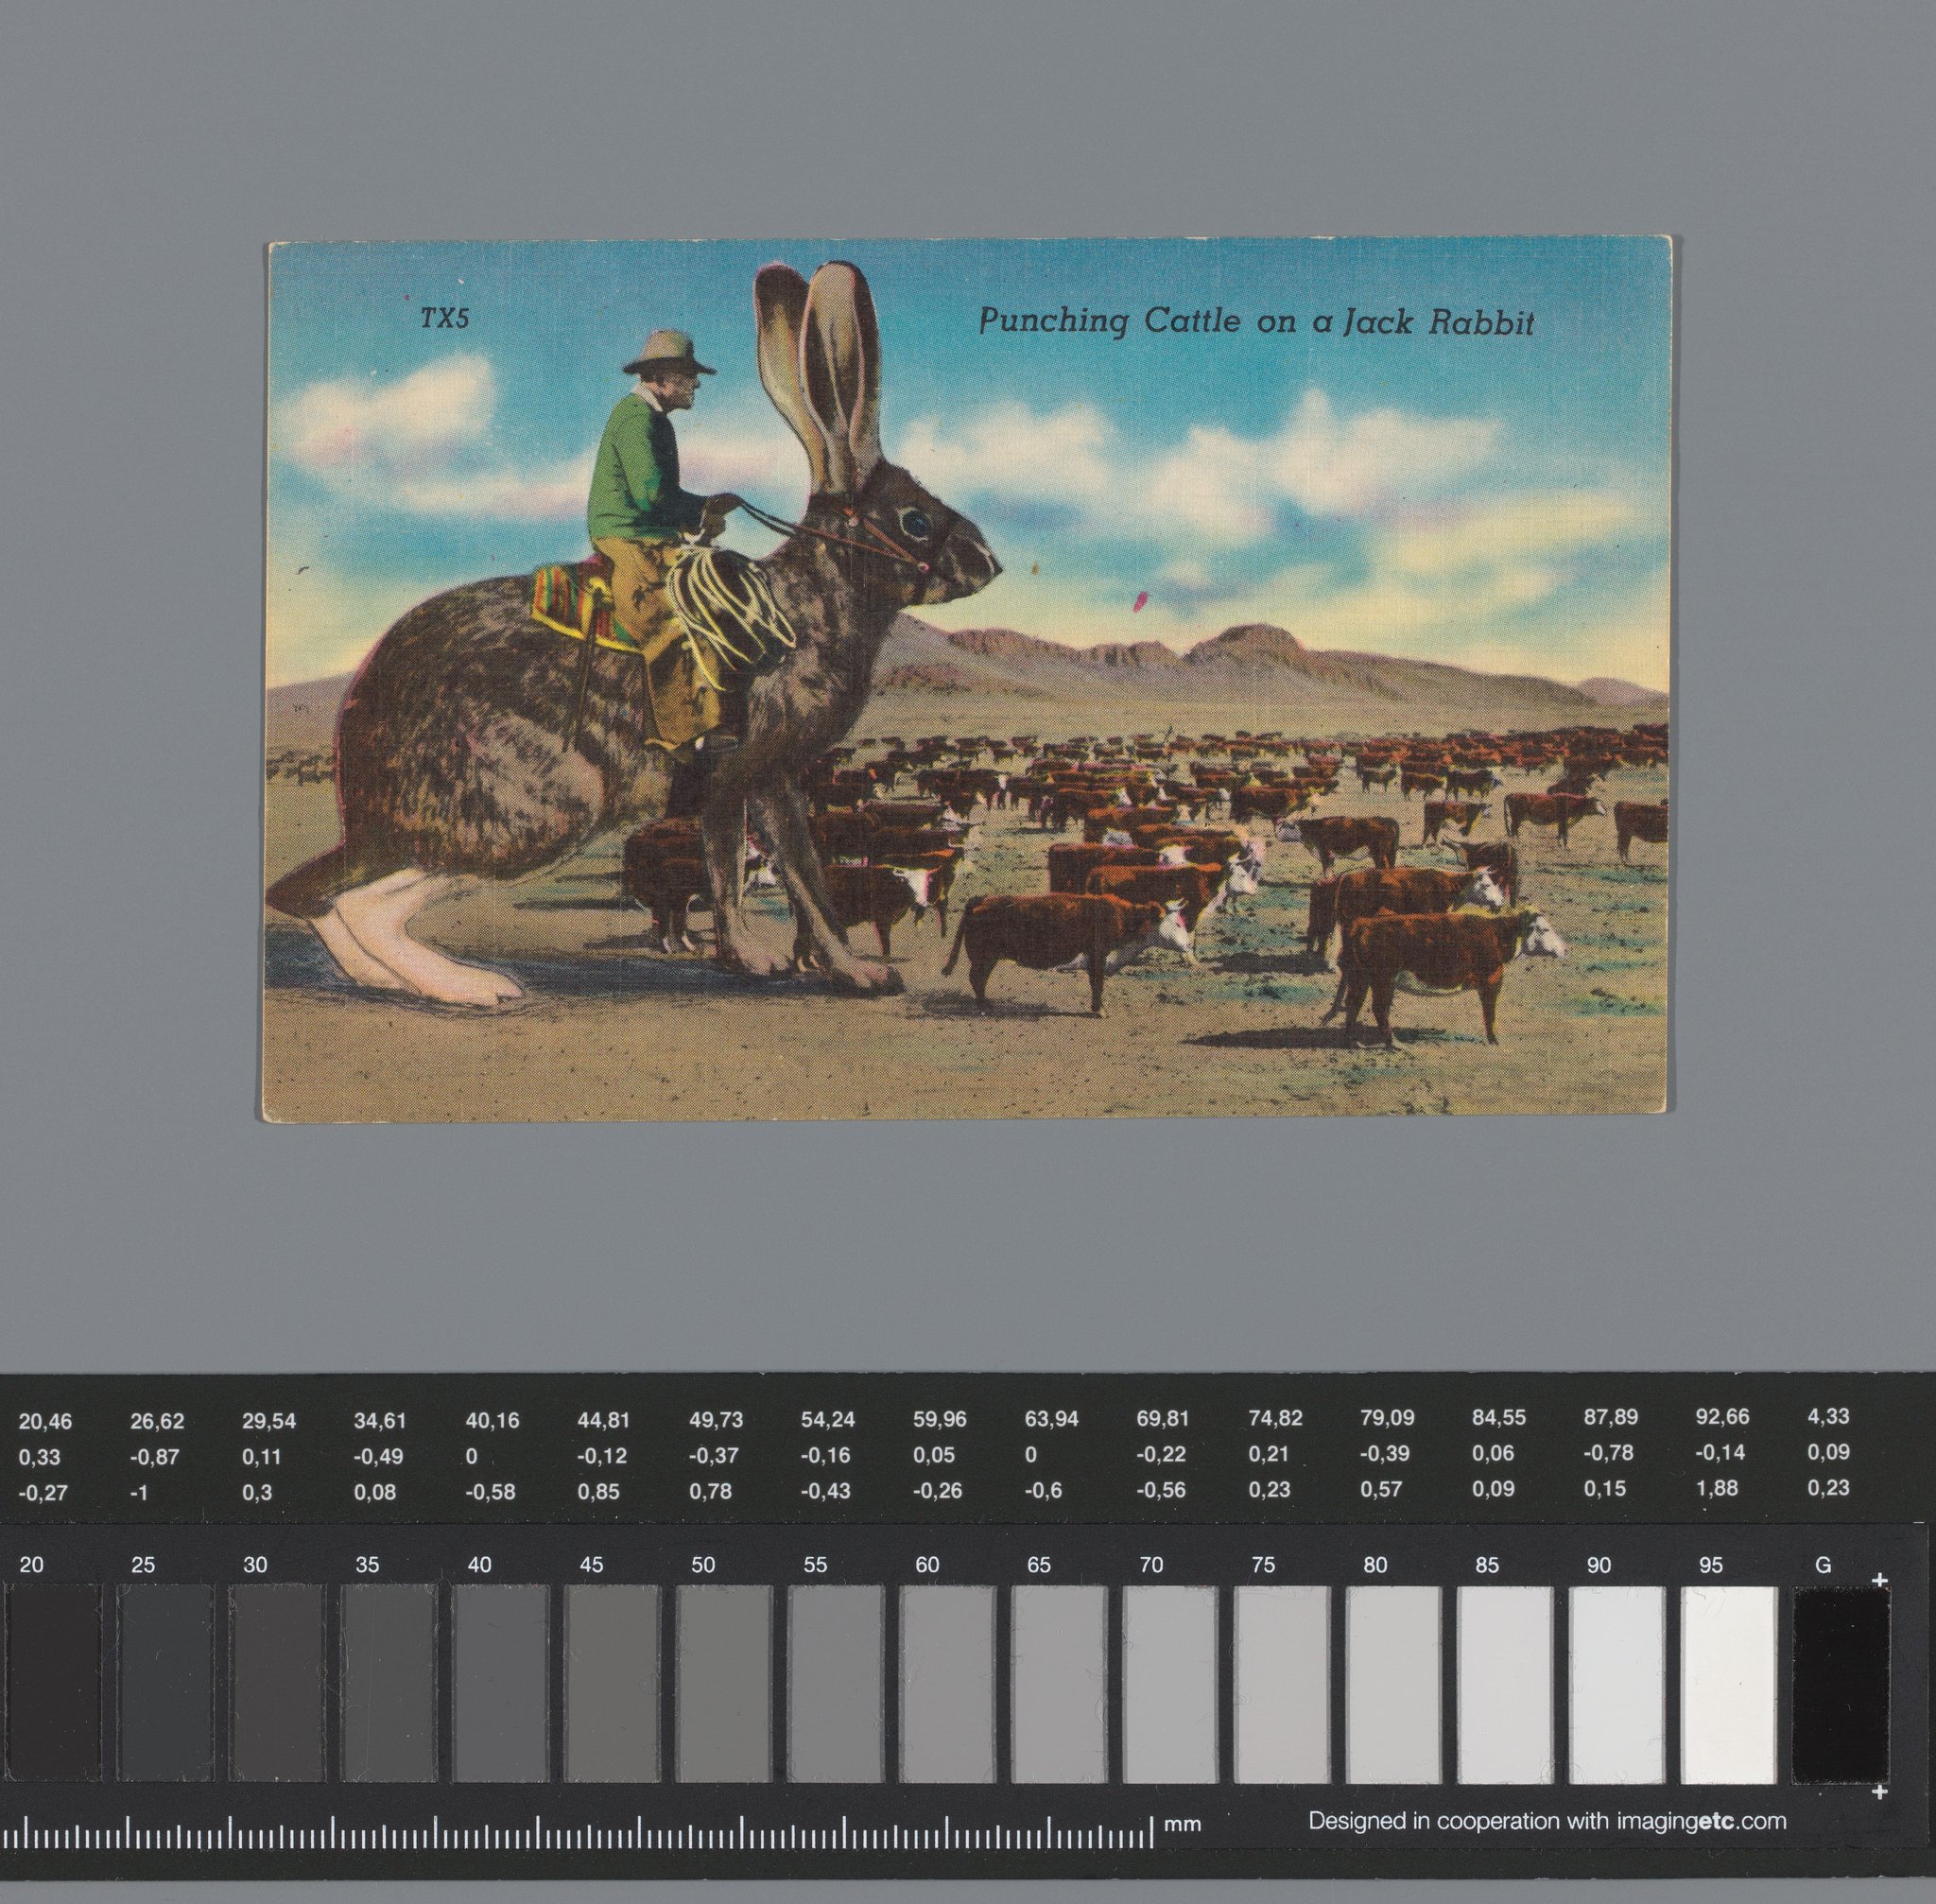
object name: ansichtkaart, prentbriefkaart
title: Punching Cattle on a Jack Rabbit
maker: Anonymous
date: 1950-1960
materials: paper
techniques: autotype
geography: boston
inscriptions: inscription: ‘TX5 Punching Cattle on a Jack Rabbit’, inscription: ‘A "COLOURPICTURE” PUBLICATION, BOSTON 15, MASS., U.S.A.’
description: Landschap met koeien en een man gezeten op een reusachtig konijn. Exaggeration.